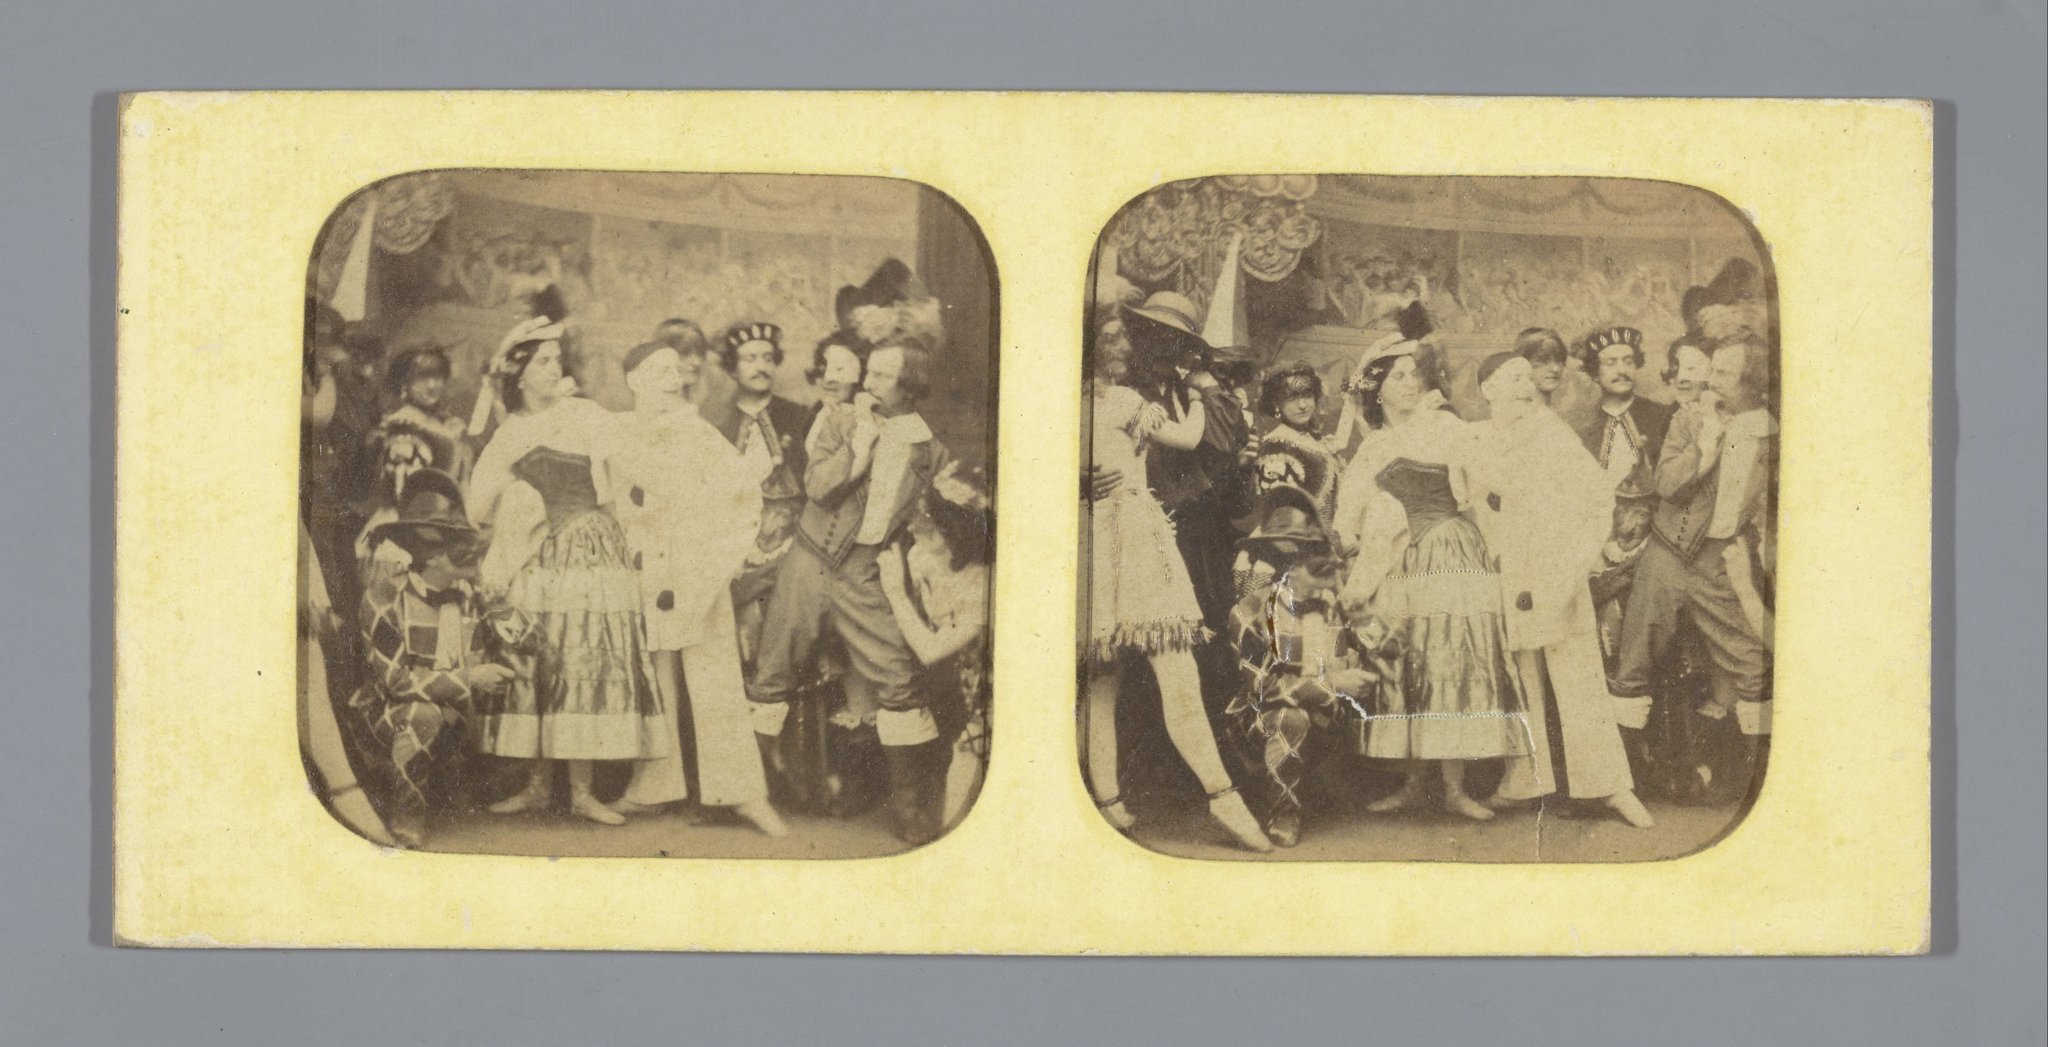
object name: tissue stereograph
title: Groep verklede mensen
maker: Anonymous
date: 1855-1875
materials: cardboard, paper, photographic support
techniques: albumen print, cutting, hand coloring, perforating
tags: party clothes, festive attire